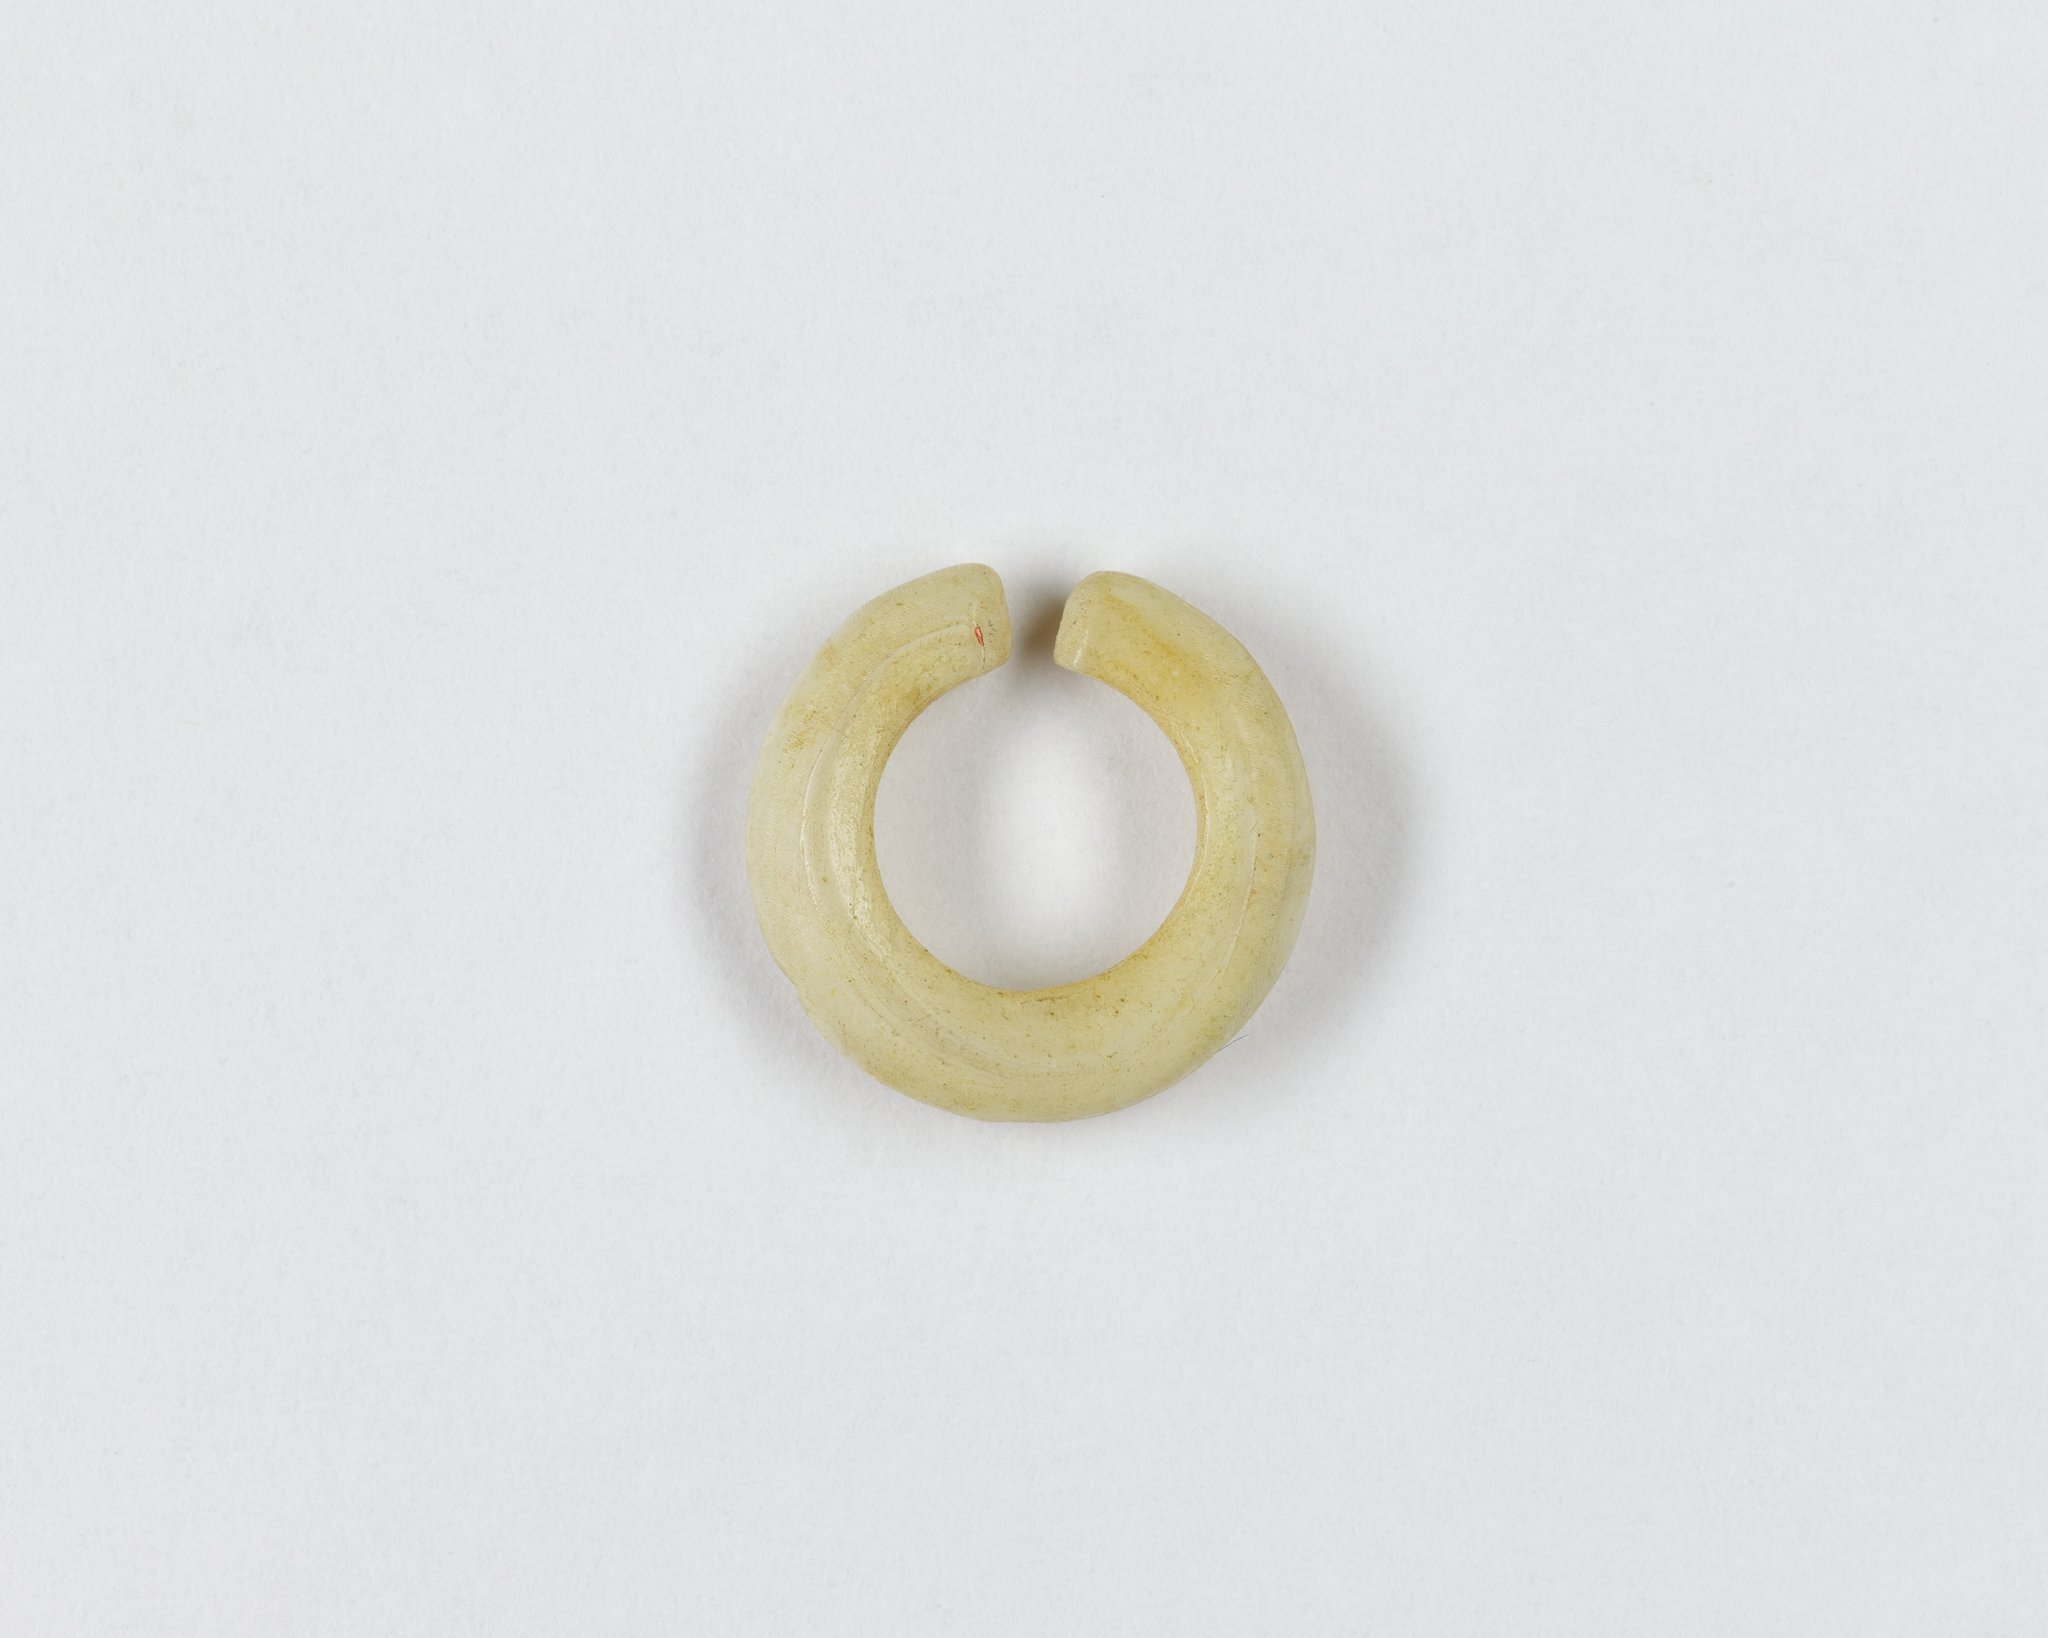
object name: earring, penannular, circular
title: Penannular Earring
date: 1550-1295 BCE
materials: shell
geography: northern upper egypt